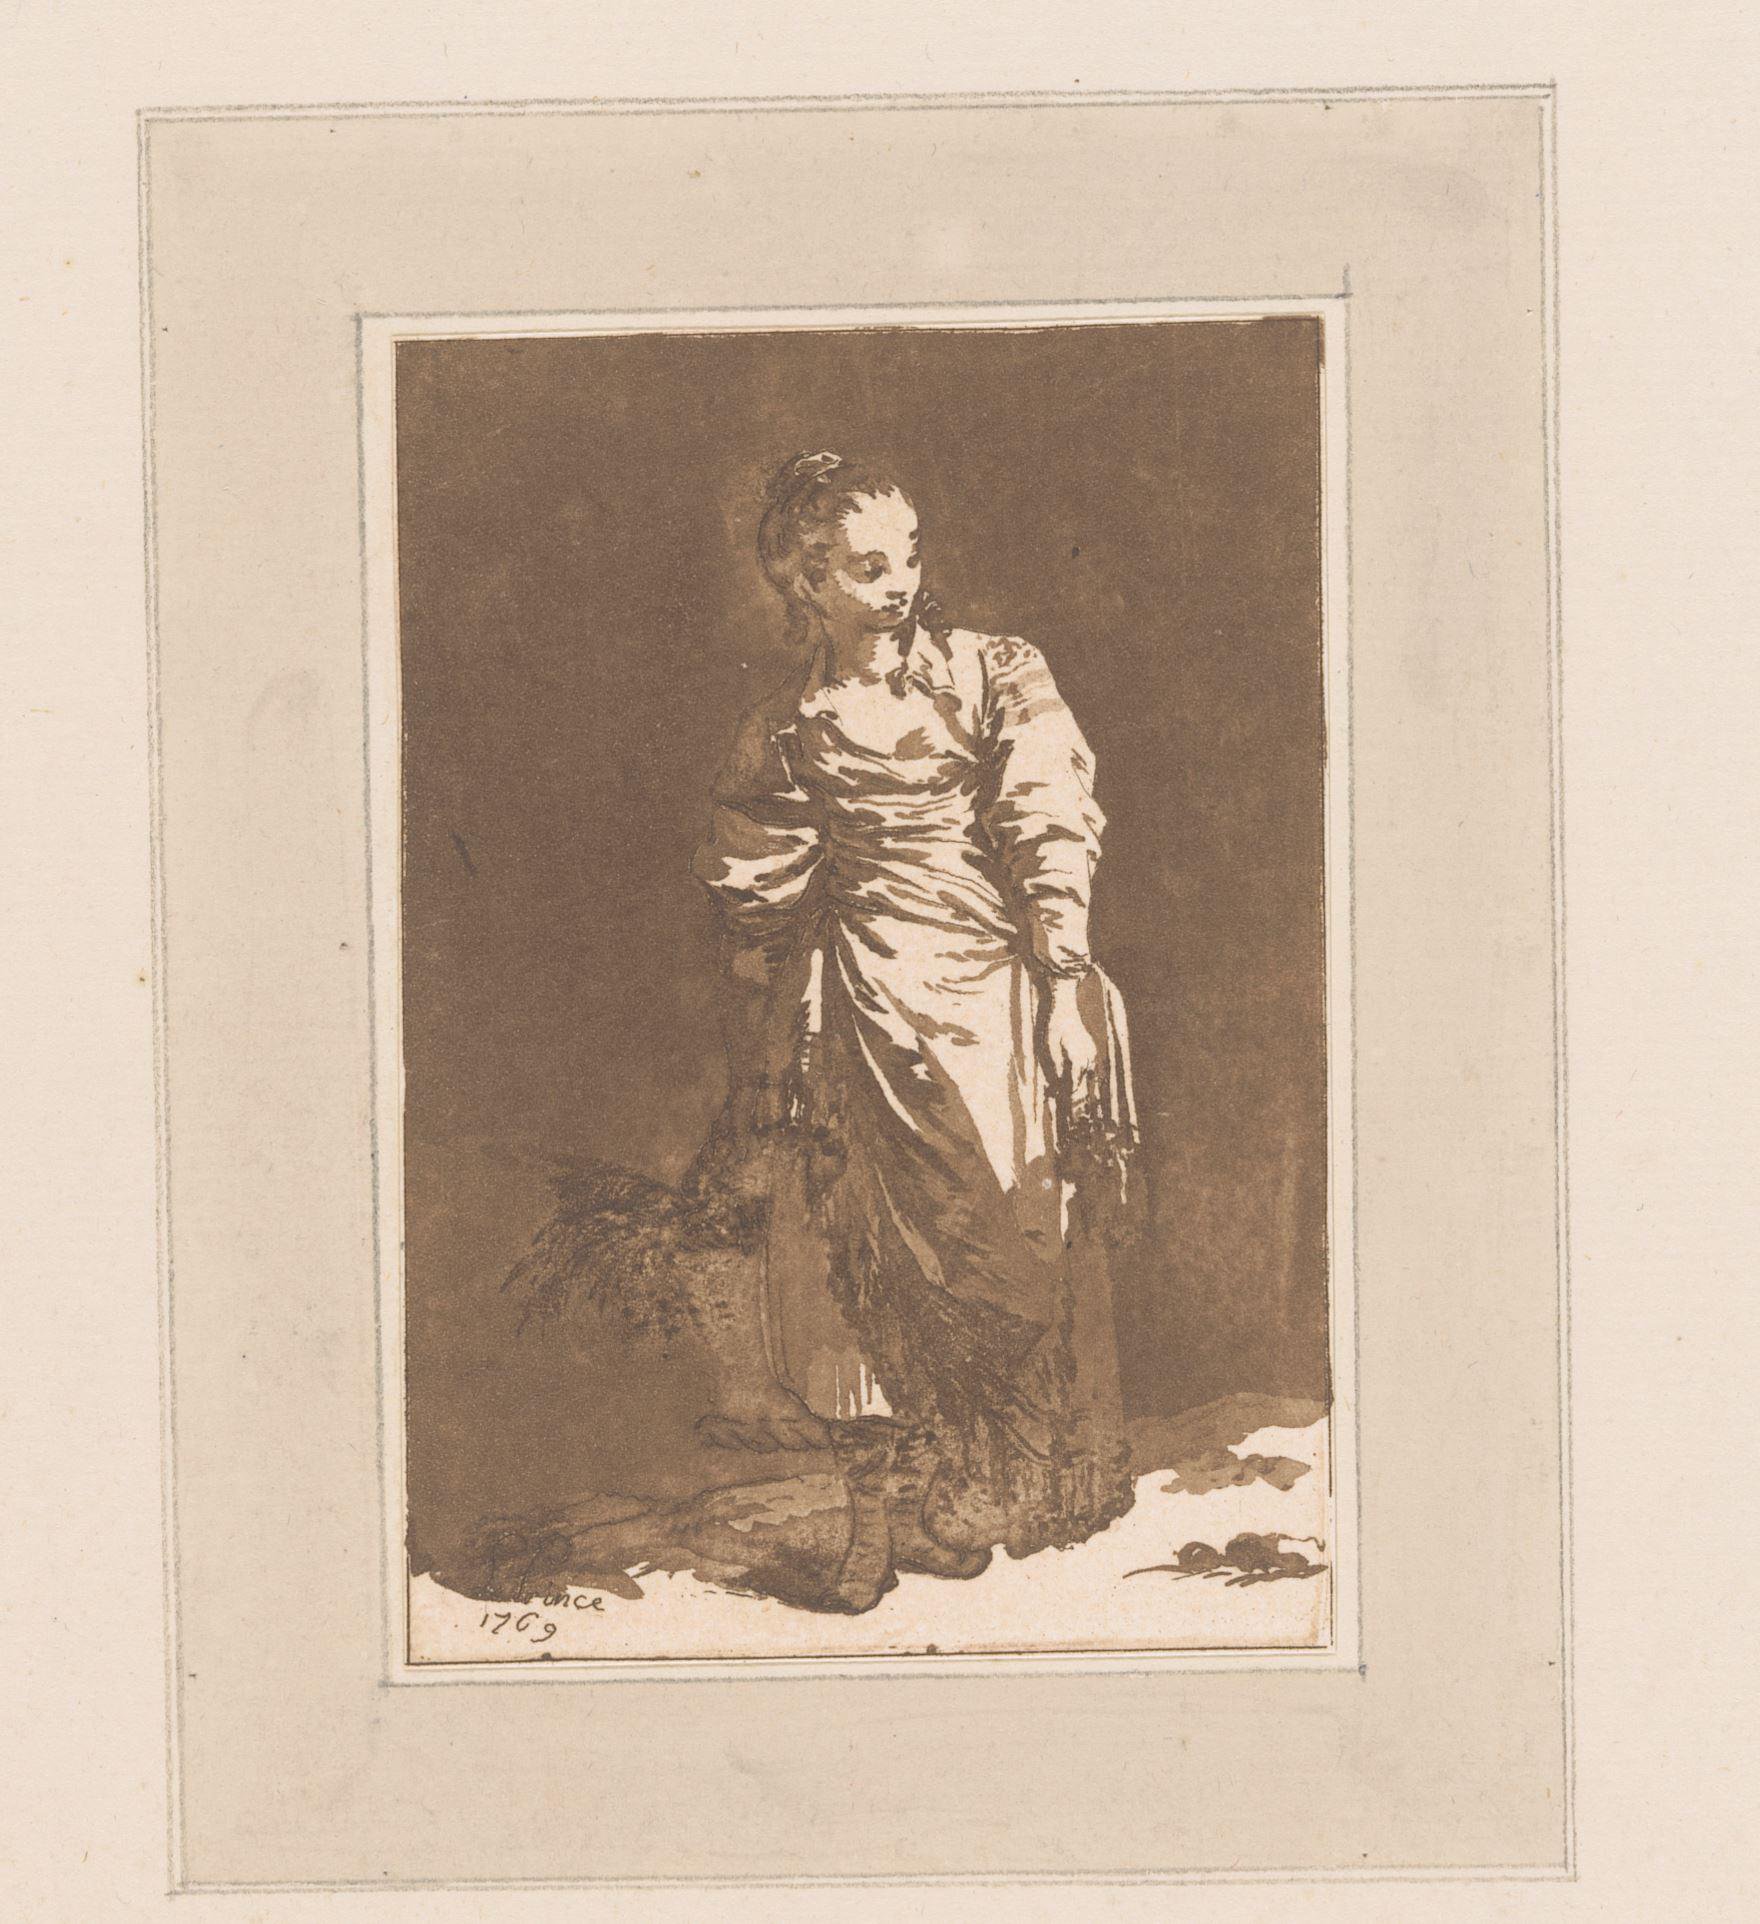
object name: print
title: Bediende met een mand bloemen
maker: jean baptist leprince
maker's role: draughtsman, print maker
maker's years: 1734-1781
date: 1769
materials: paper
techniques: aquatint, etching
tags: container made of plant material other than wood: basket, house personnel, servants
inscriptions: date